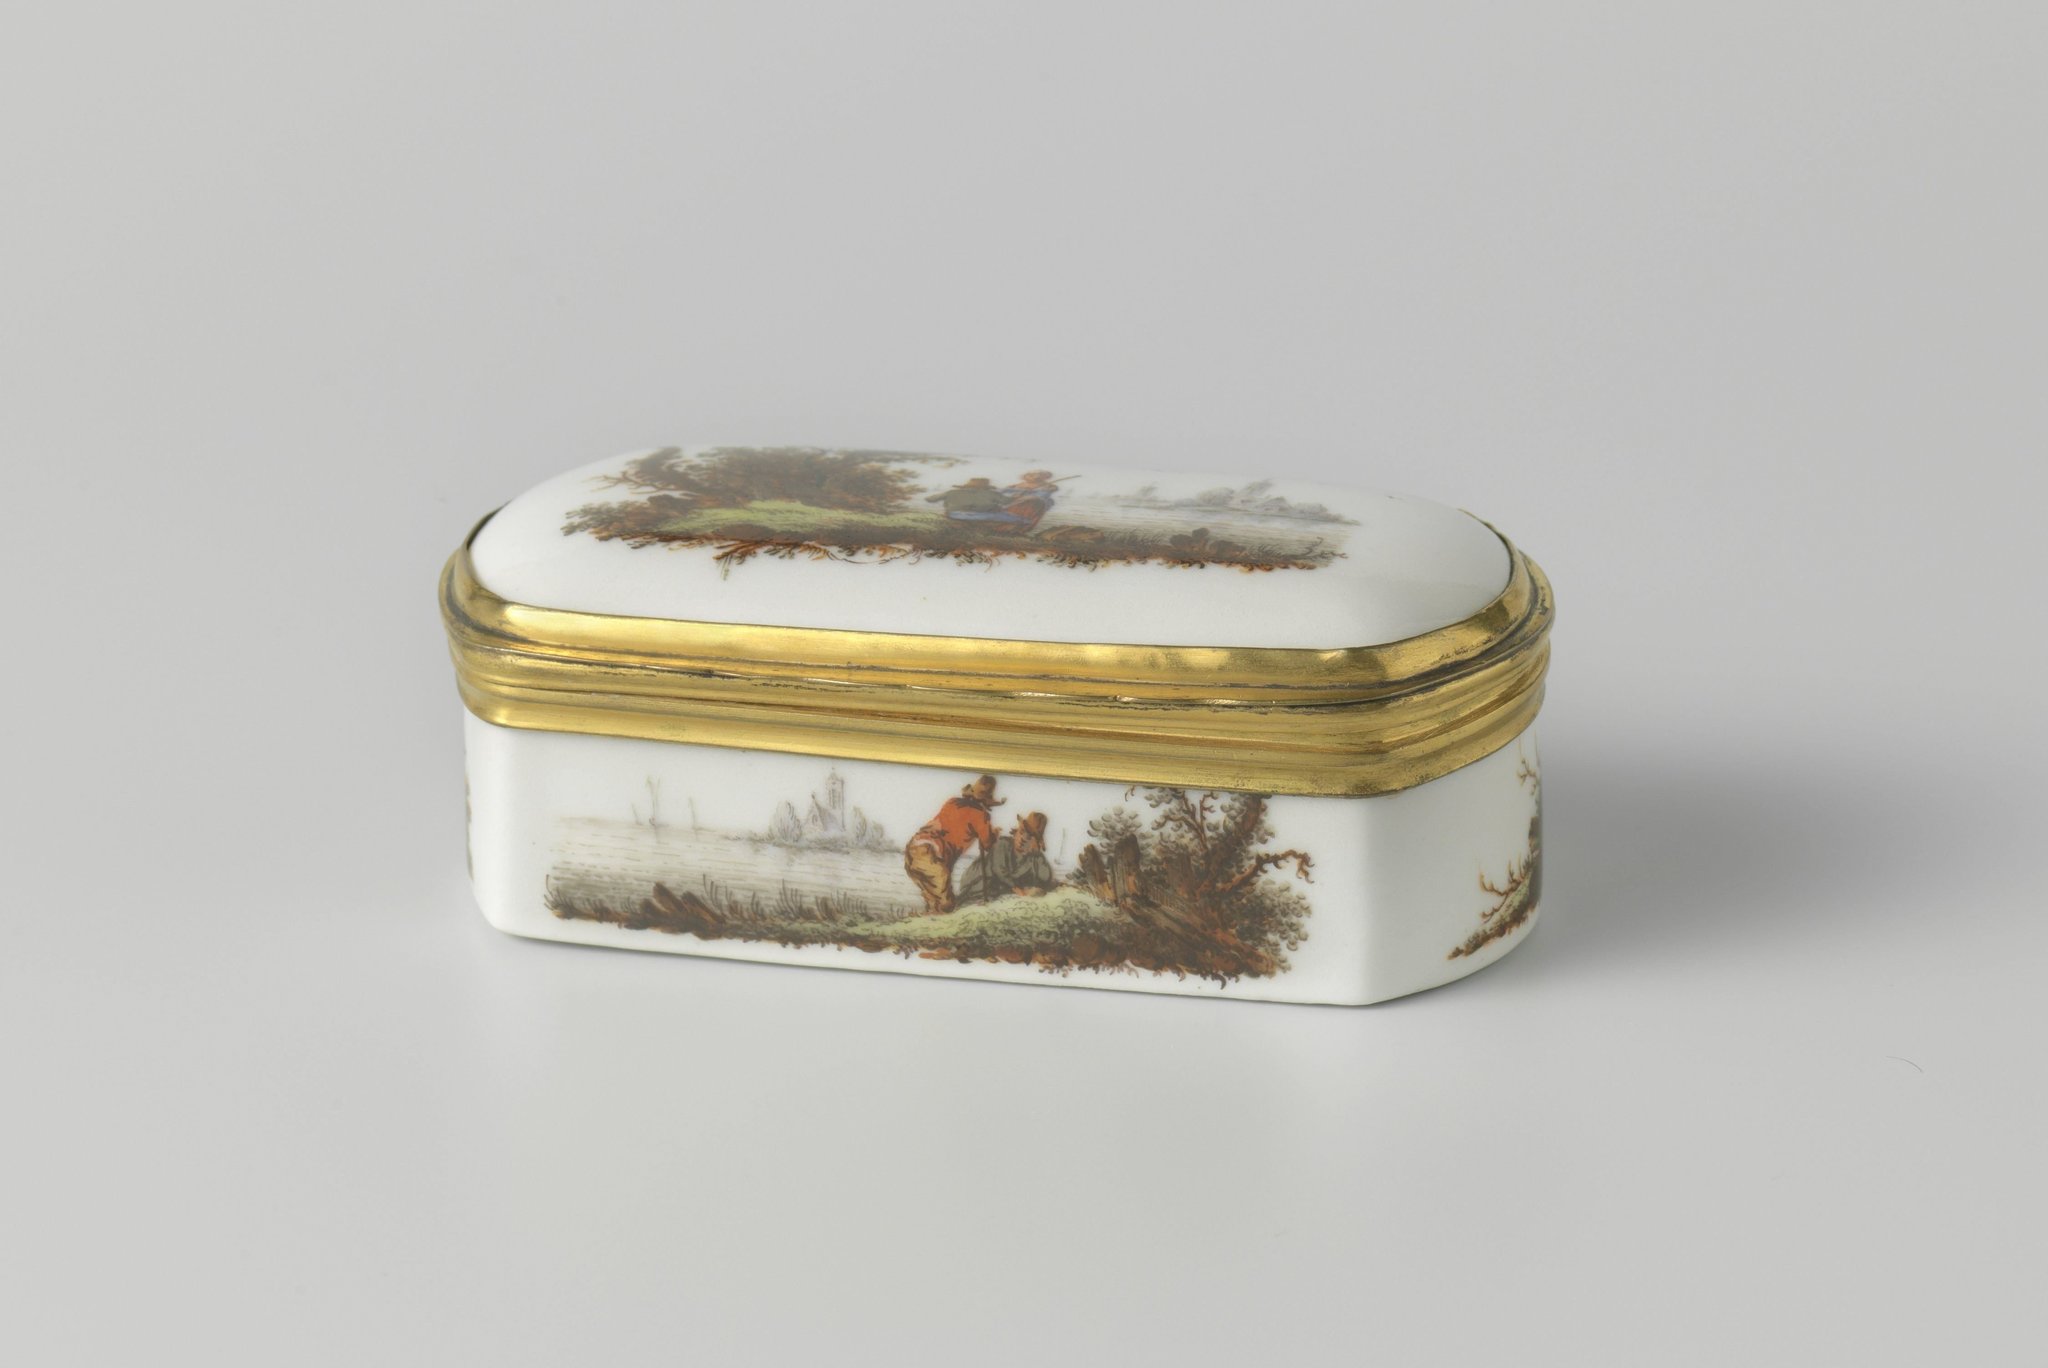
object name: snuffbox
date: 1778-1782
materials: copper, porcelain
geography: loosdrecht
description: Manufactuur Oud-Loosdrecht Loosdrecht, c. 1778–1782 hard-paste porcelain, silver gilt